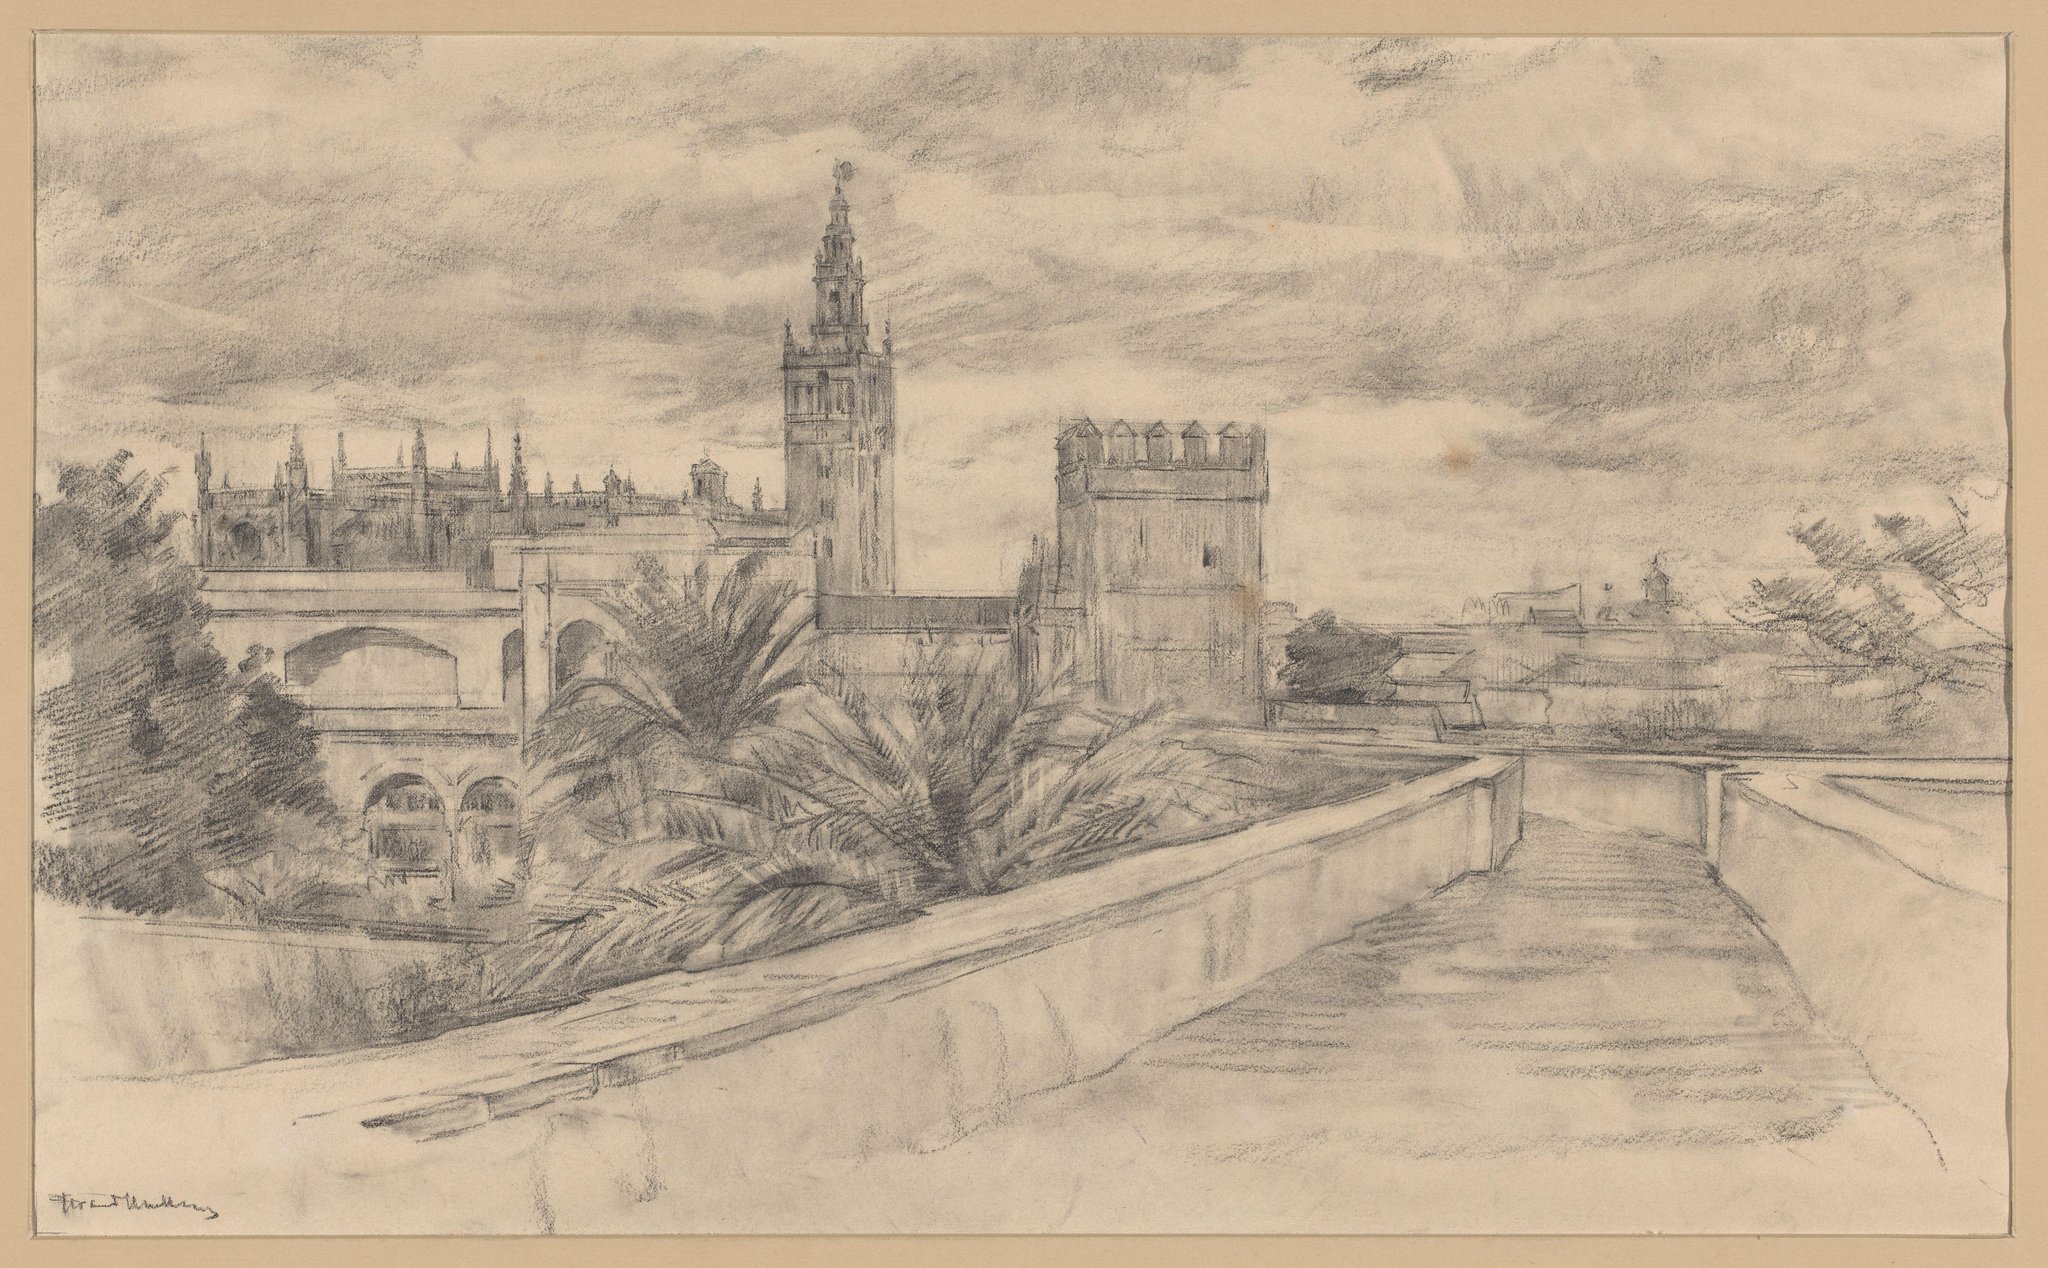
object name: drawing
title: Gezicht op de tuinen van het Koninklijk Paleis te Sevilla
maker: gerard muller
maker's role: draughtsman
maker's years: 1861-1929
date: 1871-1903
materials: chalk, paper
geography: sevilla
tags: garden, palace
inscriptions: label: ‘8. Alcázar - Sevilla/ Gezicht op de tuinen.’, collector's mark: Lugt 2228